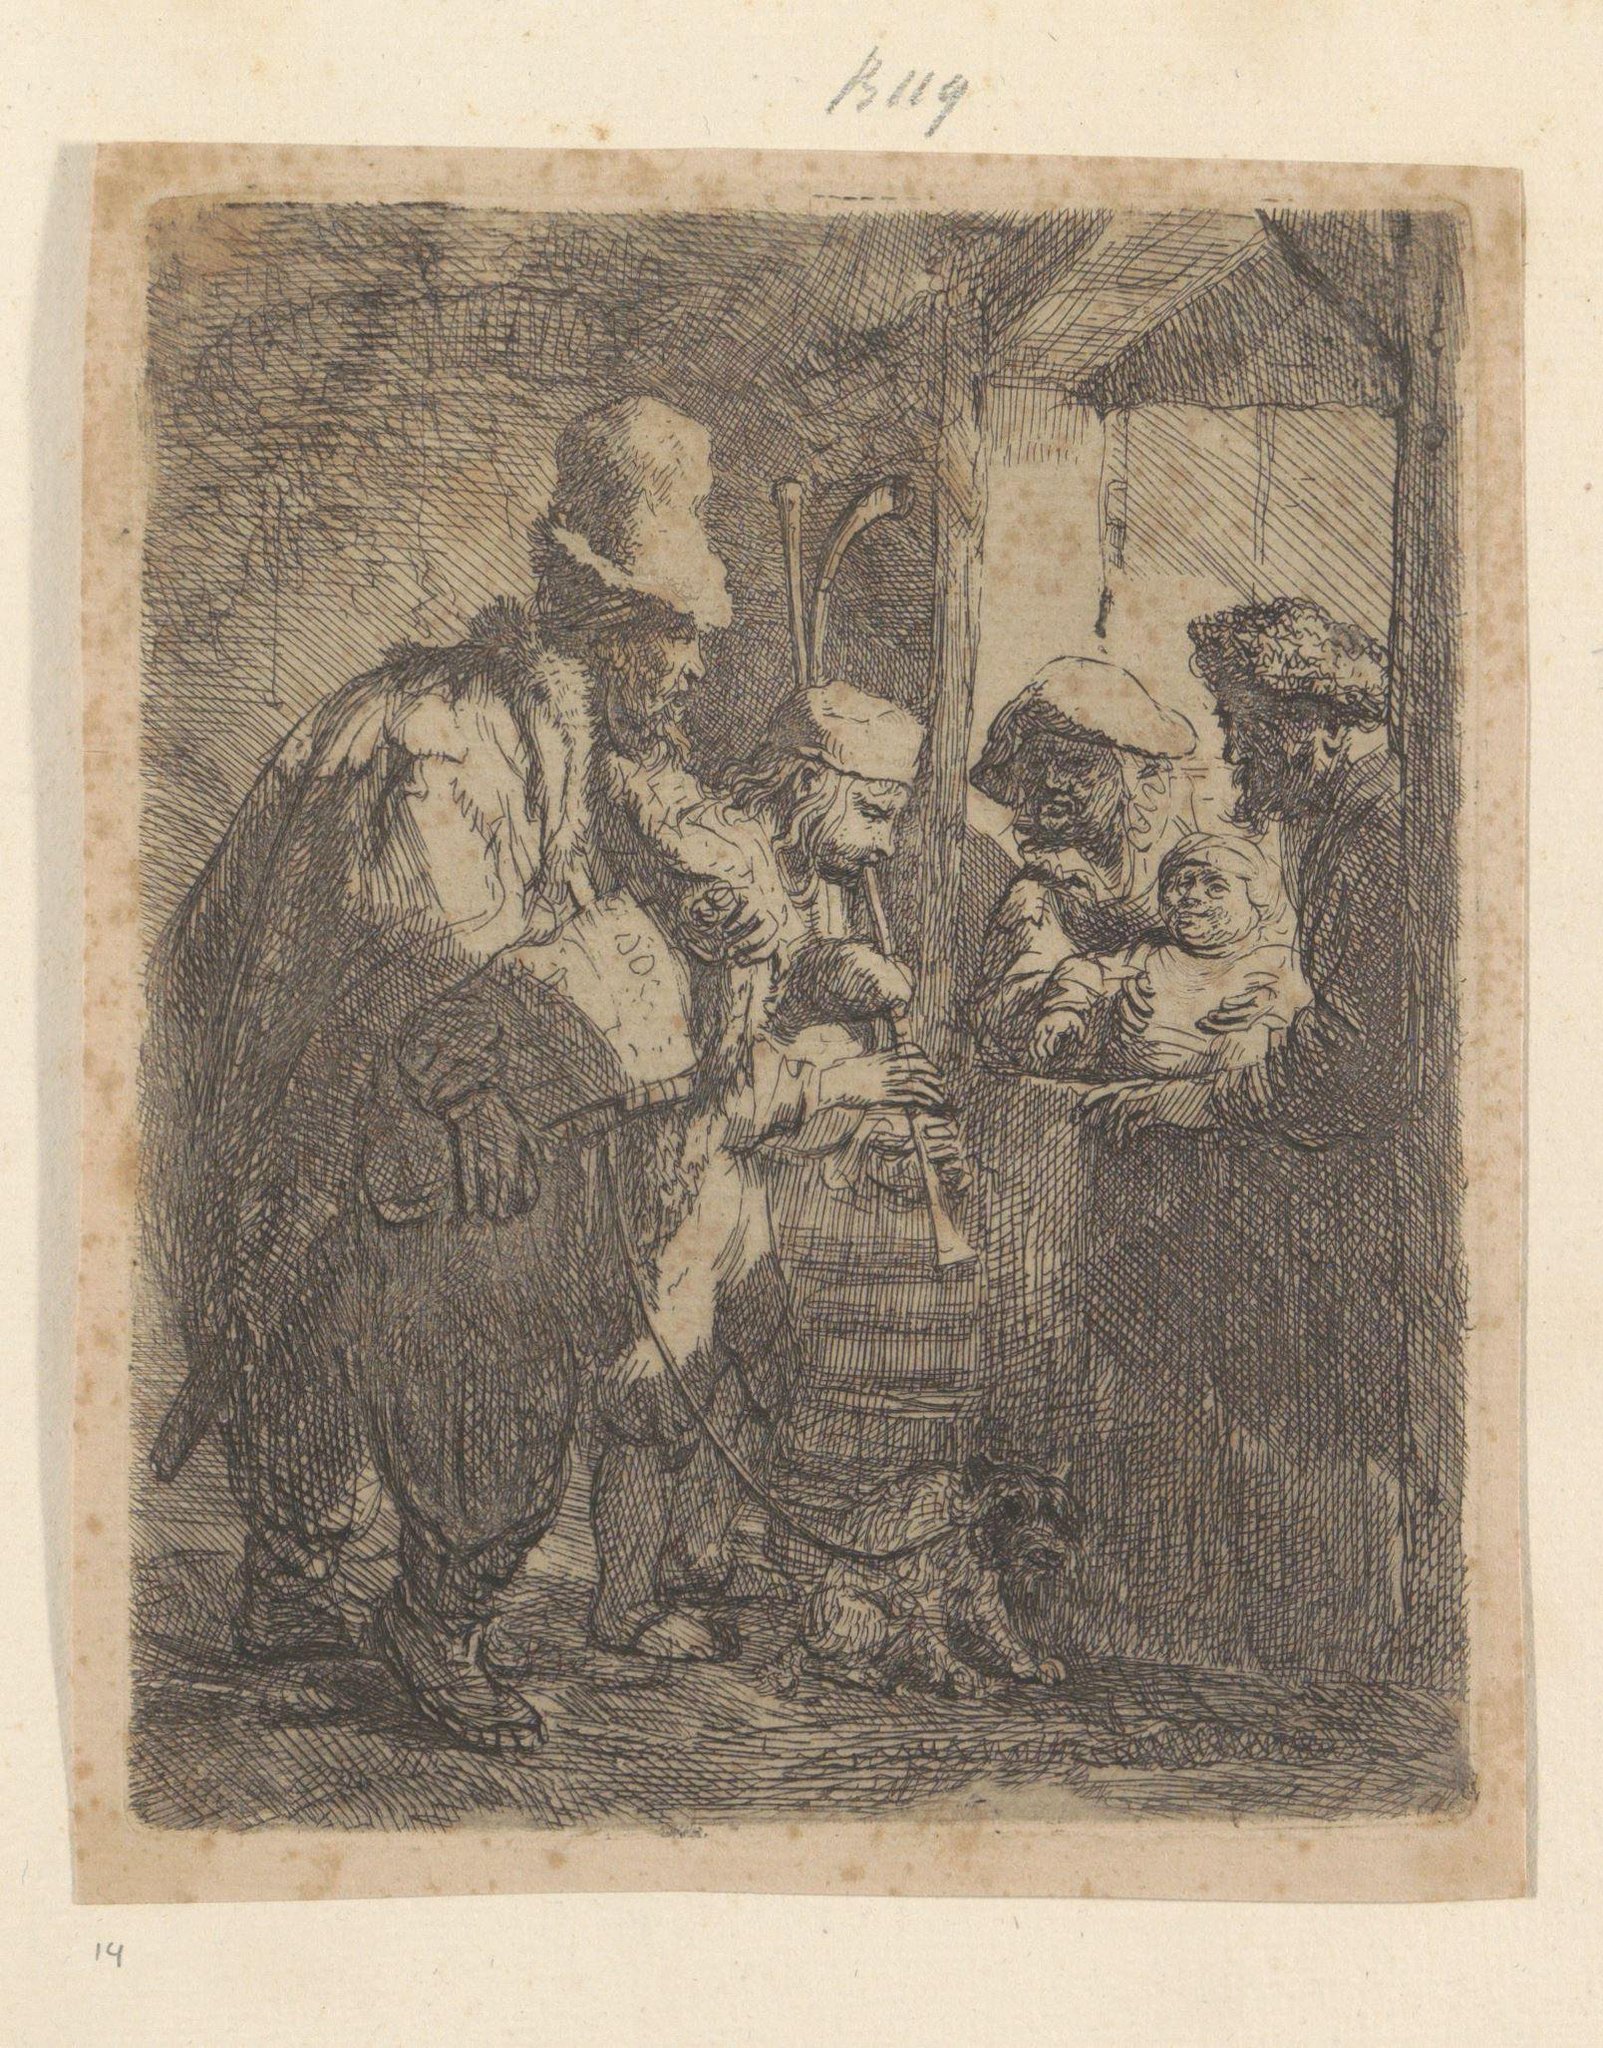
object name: print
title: Recueil de quatre-vingt-cinq estampes originales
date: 1632-1637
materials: paper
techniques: etching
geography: paris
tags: more than one musician with instrument